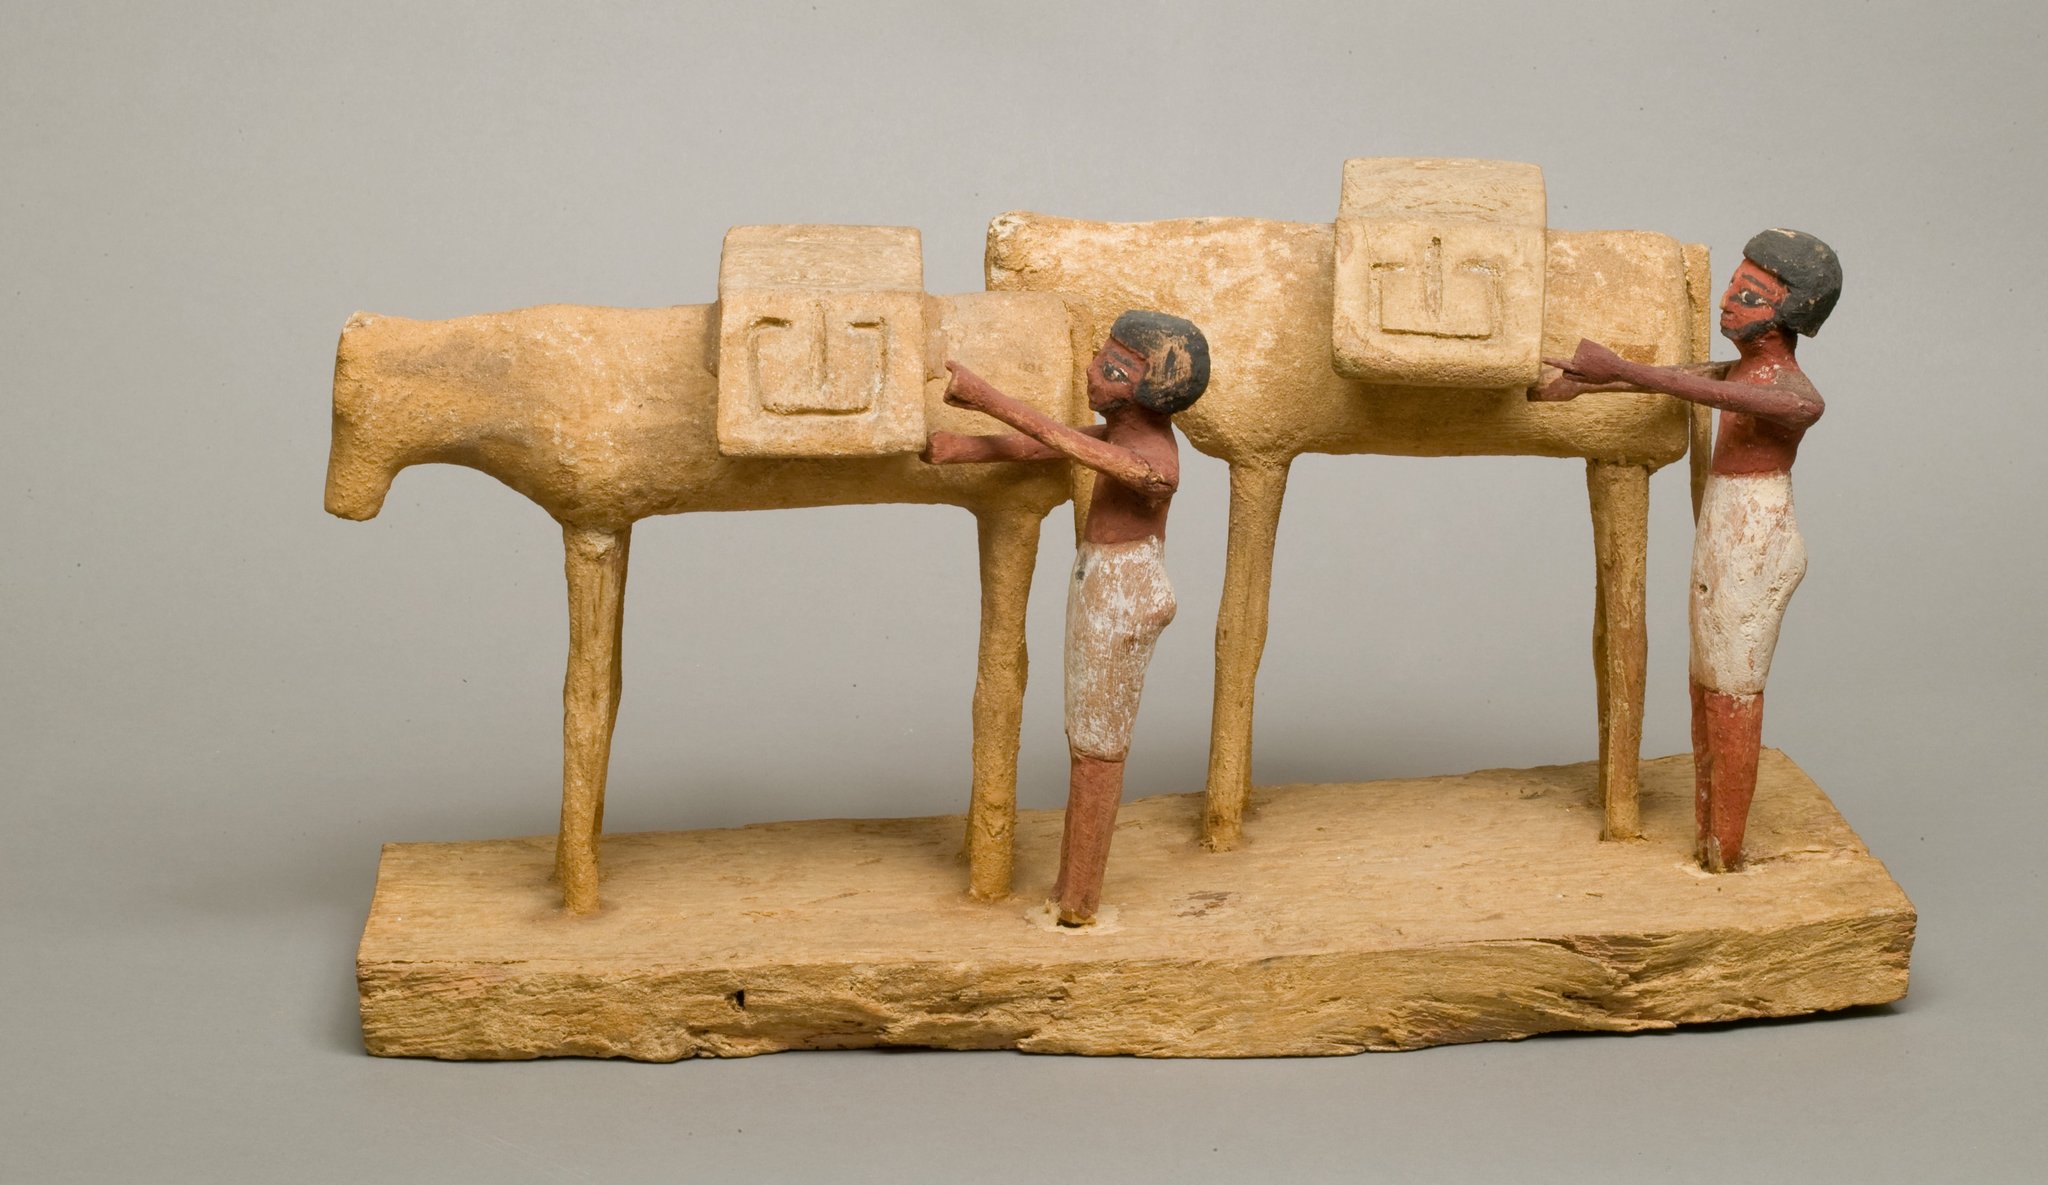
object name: model, saddle bag, donkey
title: Model of Two Donkeys with Drivers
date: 2030-1850 BCE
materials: paint, wood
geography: egypt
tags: men,donkeys